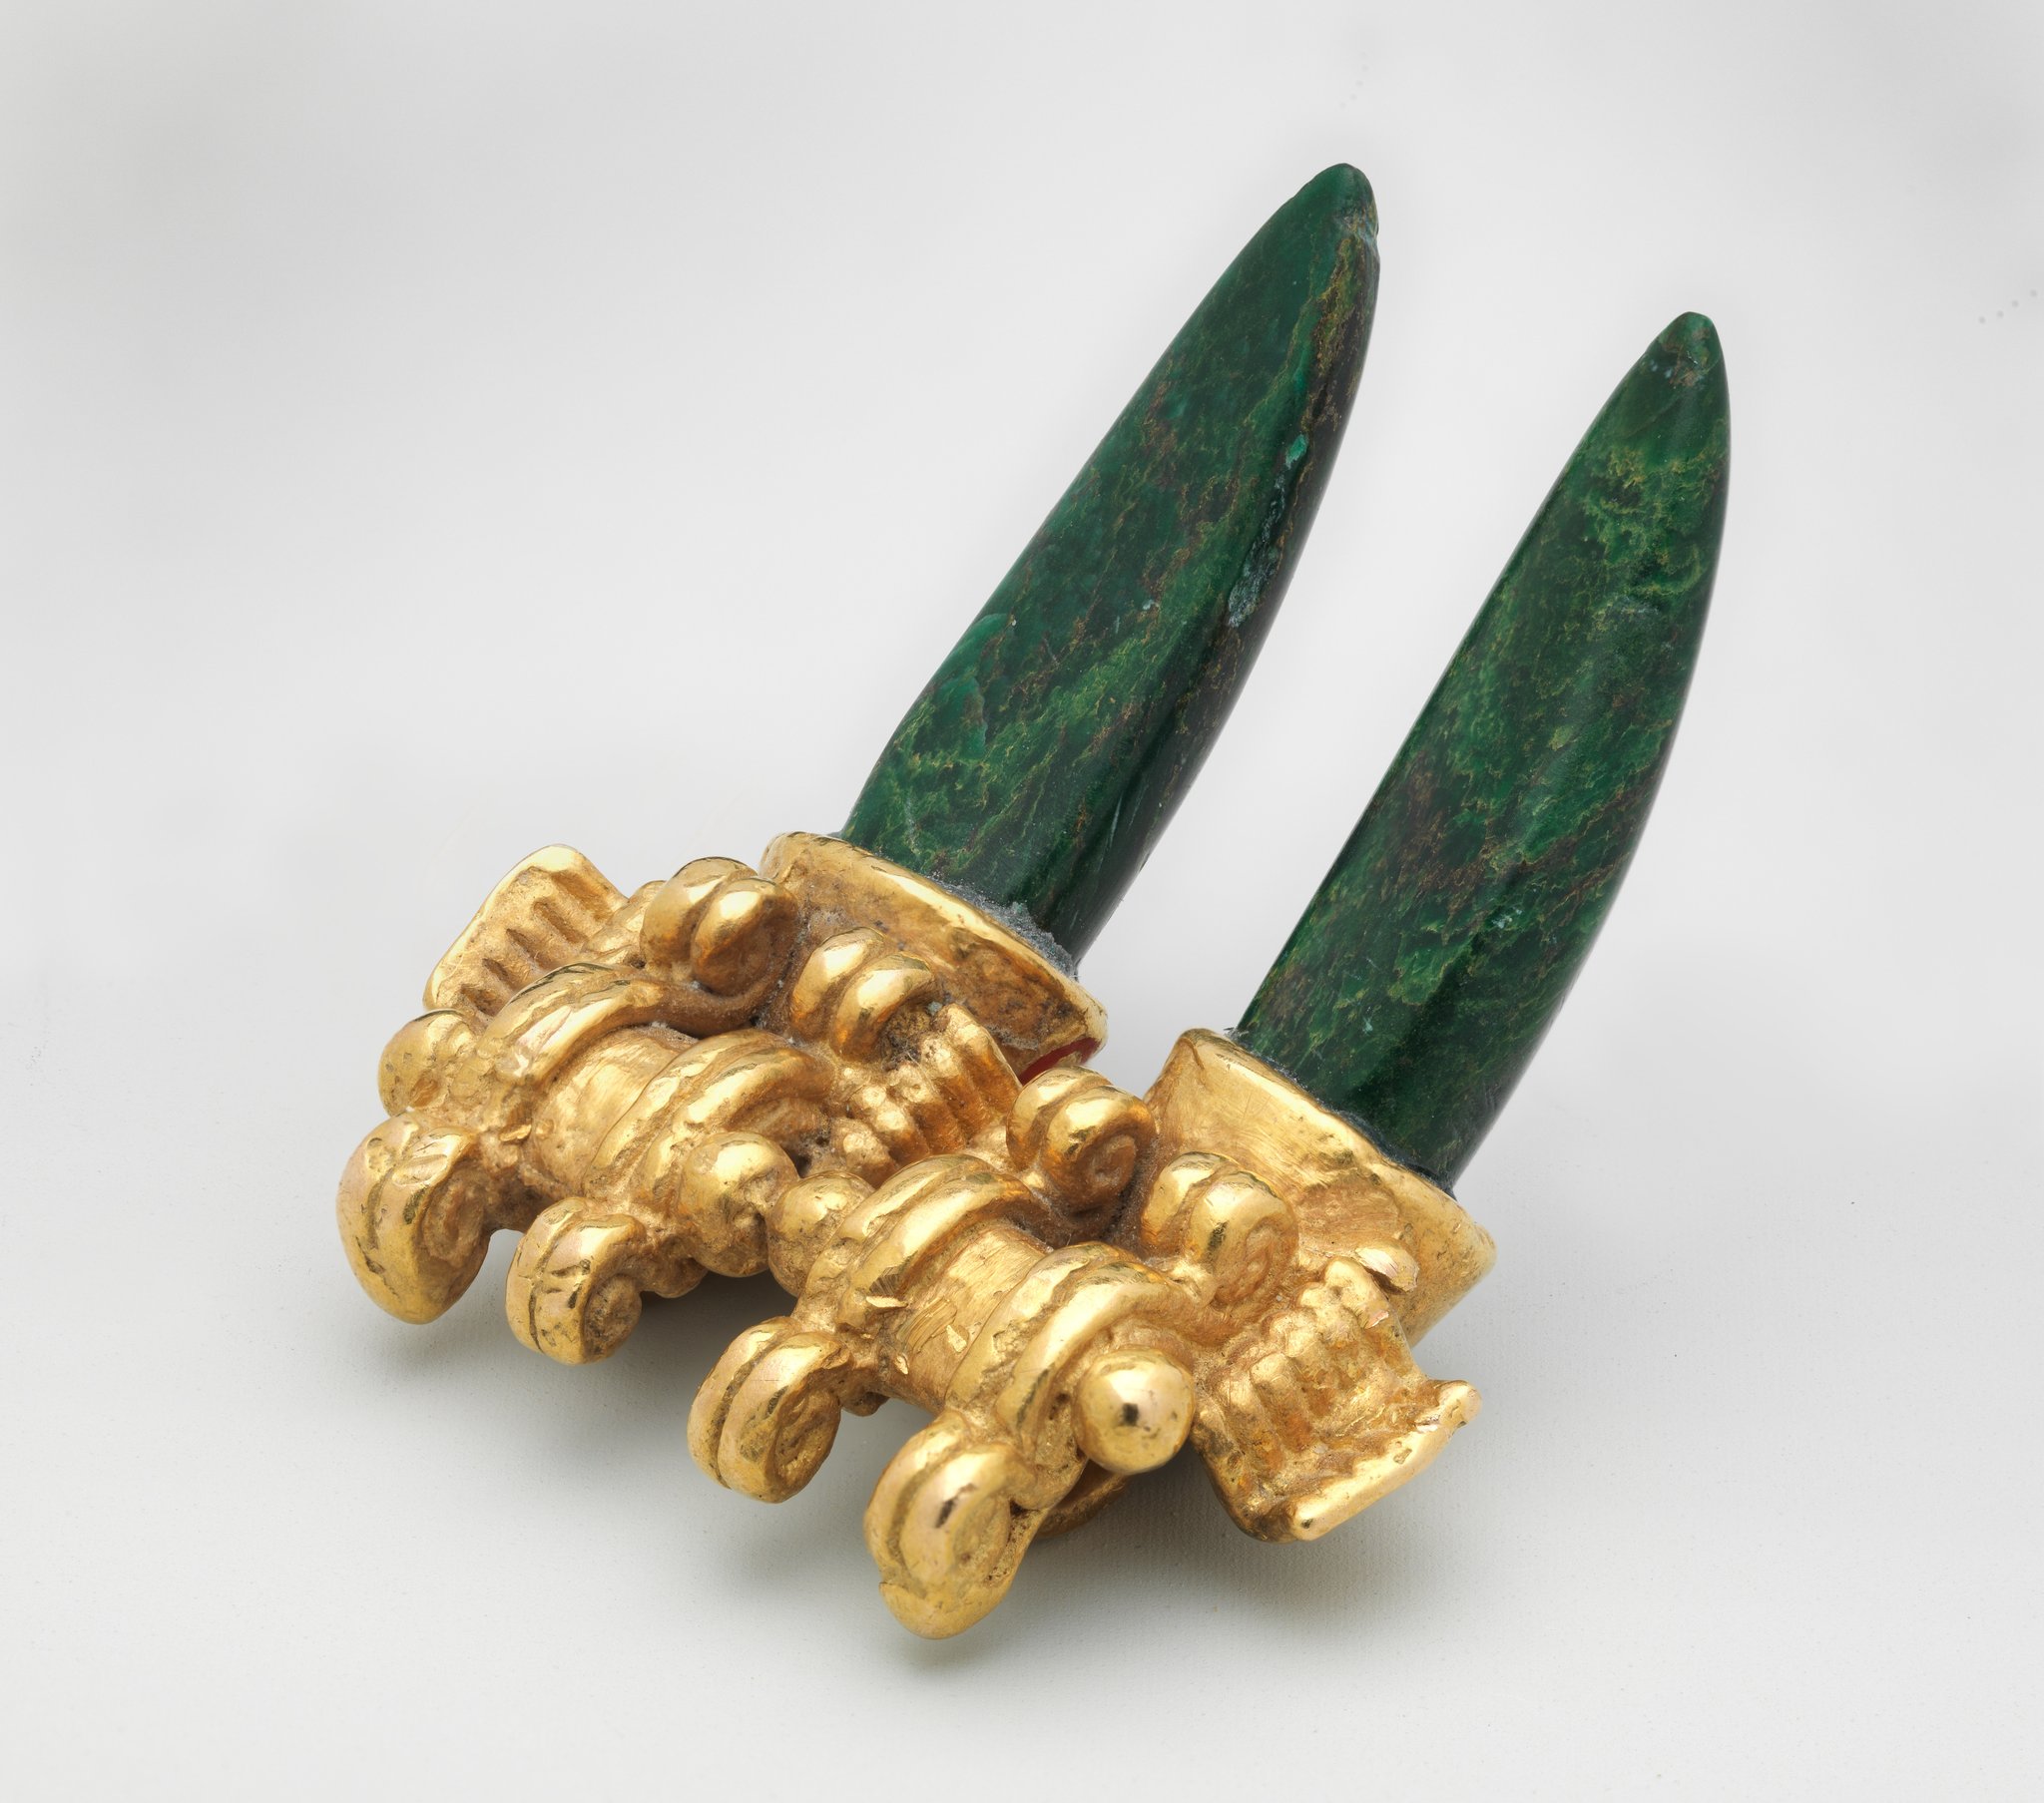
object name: pendant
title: Double-crocodile pendant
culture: coclé, macaracas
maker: coclé (macaracas) artist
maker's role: artist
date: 950-1100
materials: gold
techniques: casting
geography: panama